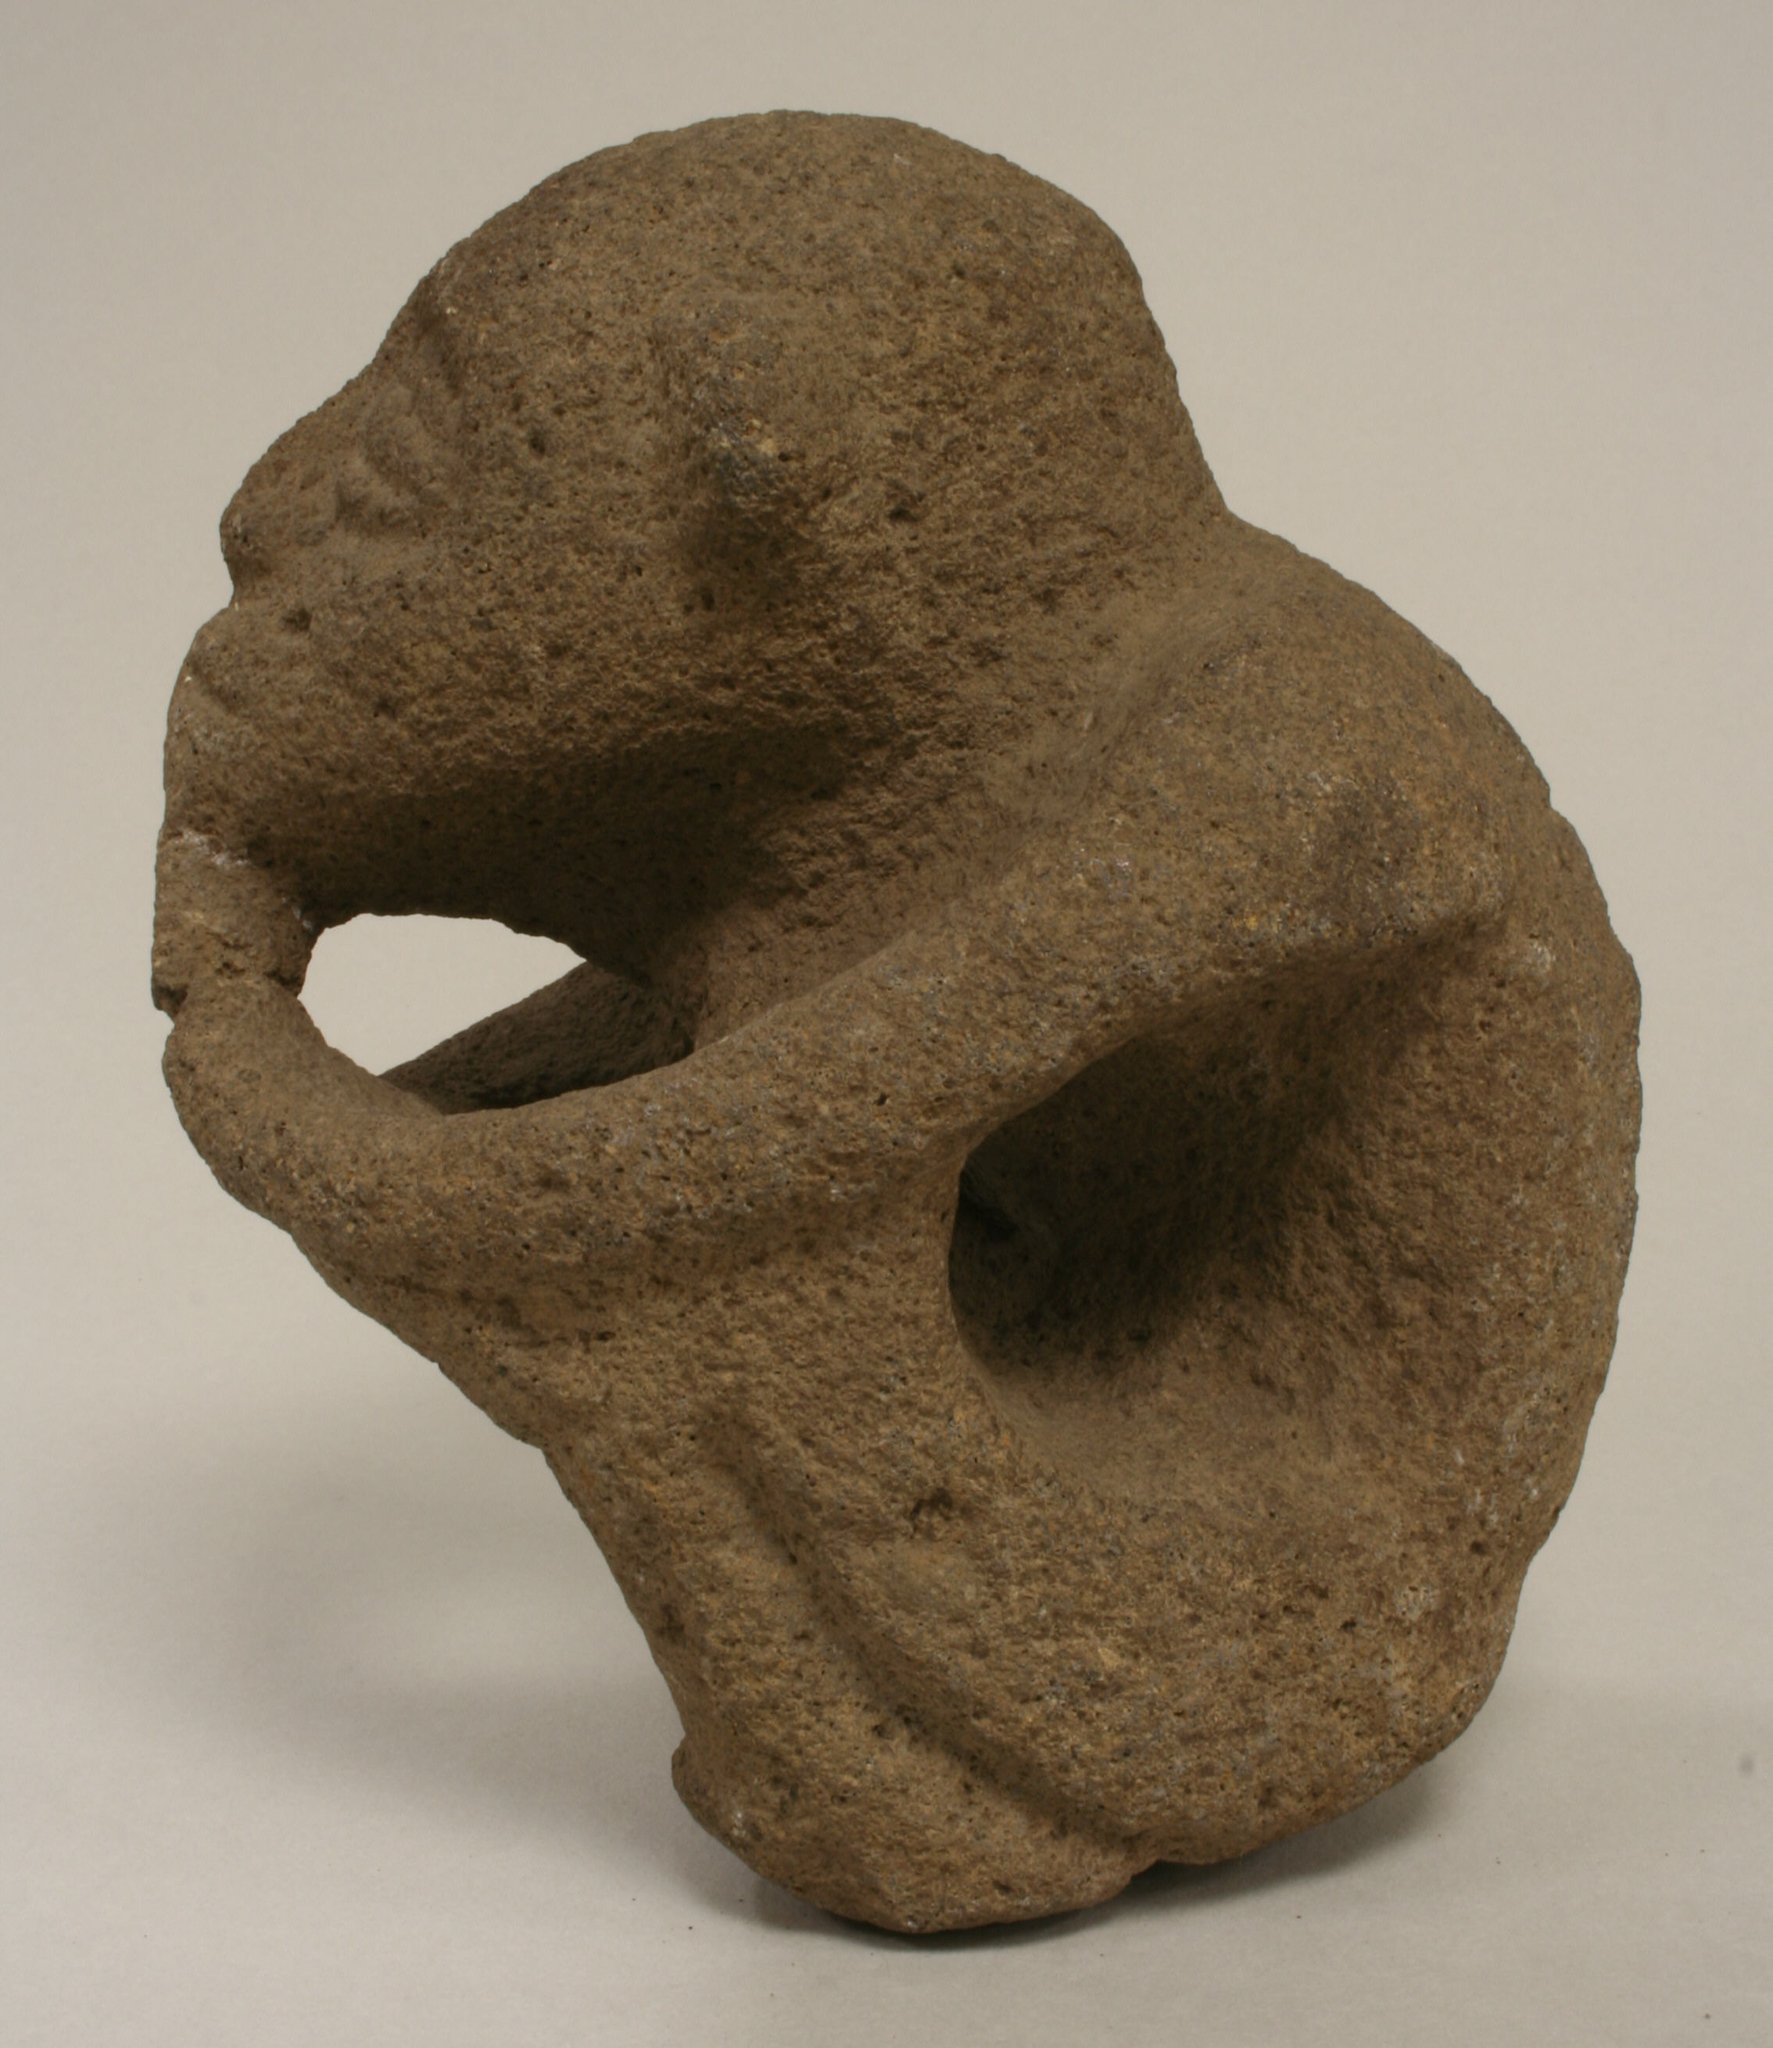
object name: figure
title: Sukia Figure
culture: atlantic watershed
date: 1001-1600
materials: stone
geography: costa rica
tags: human figures